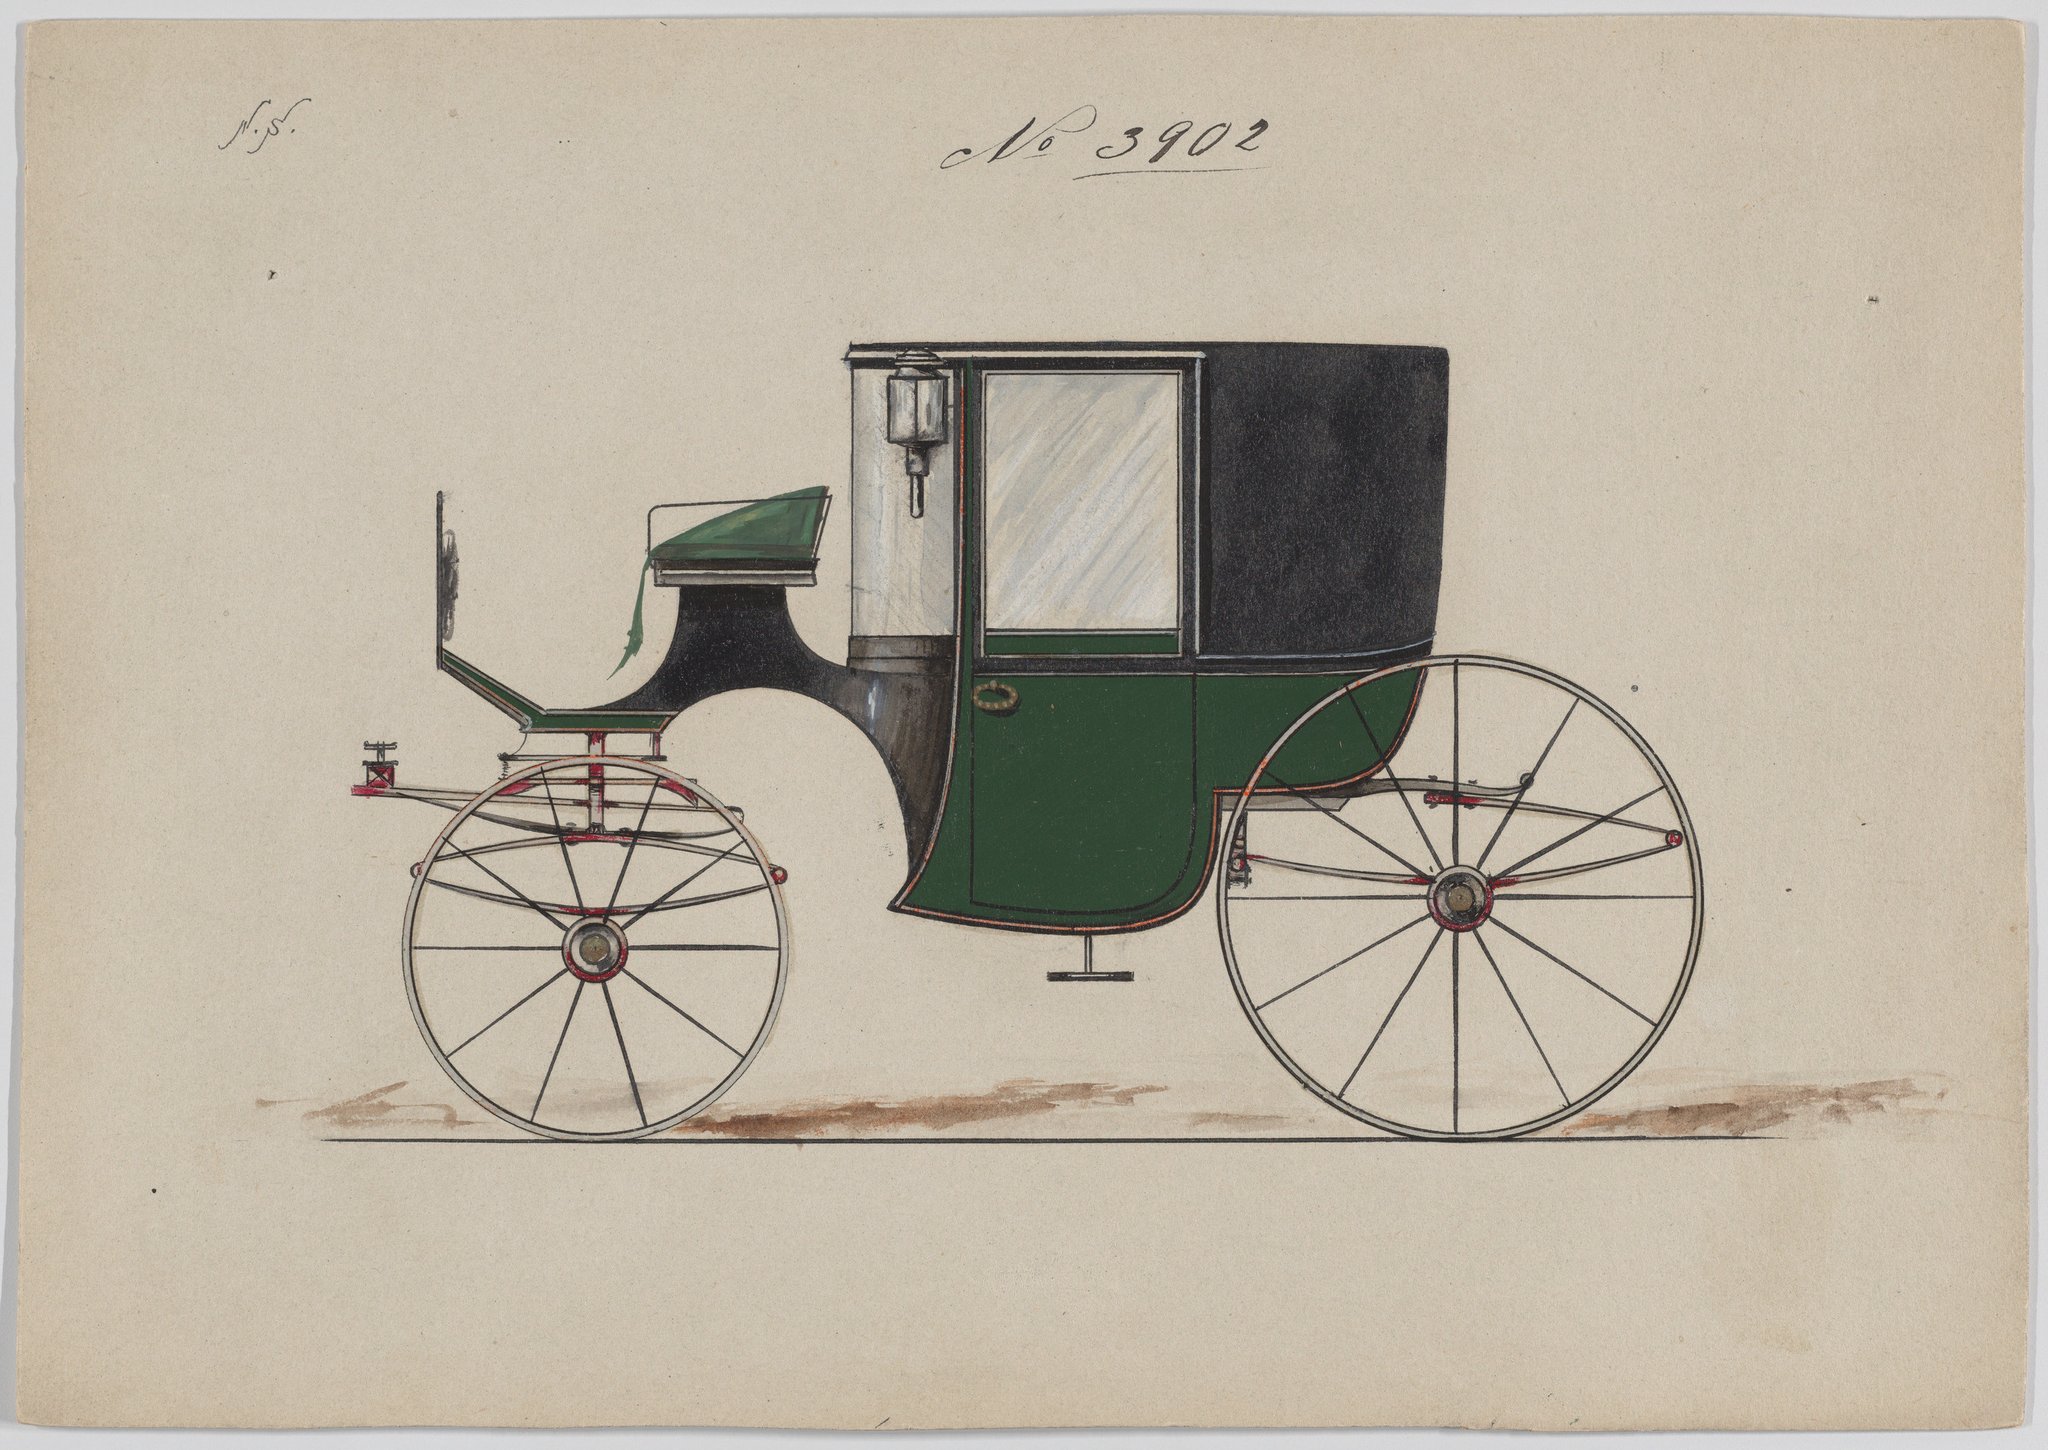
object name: drawing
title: Design for Coupé, no. 3902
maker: brewster & co.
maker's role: manufacturer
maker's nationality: american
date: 1884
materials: gouache, gum arabic, ink, watercolor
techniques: pen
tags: carriages